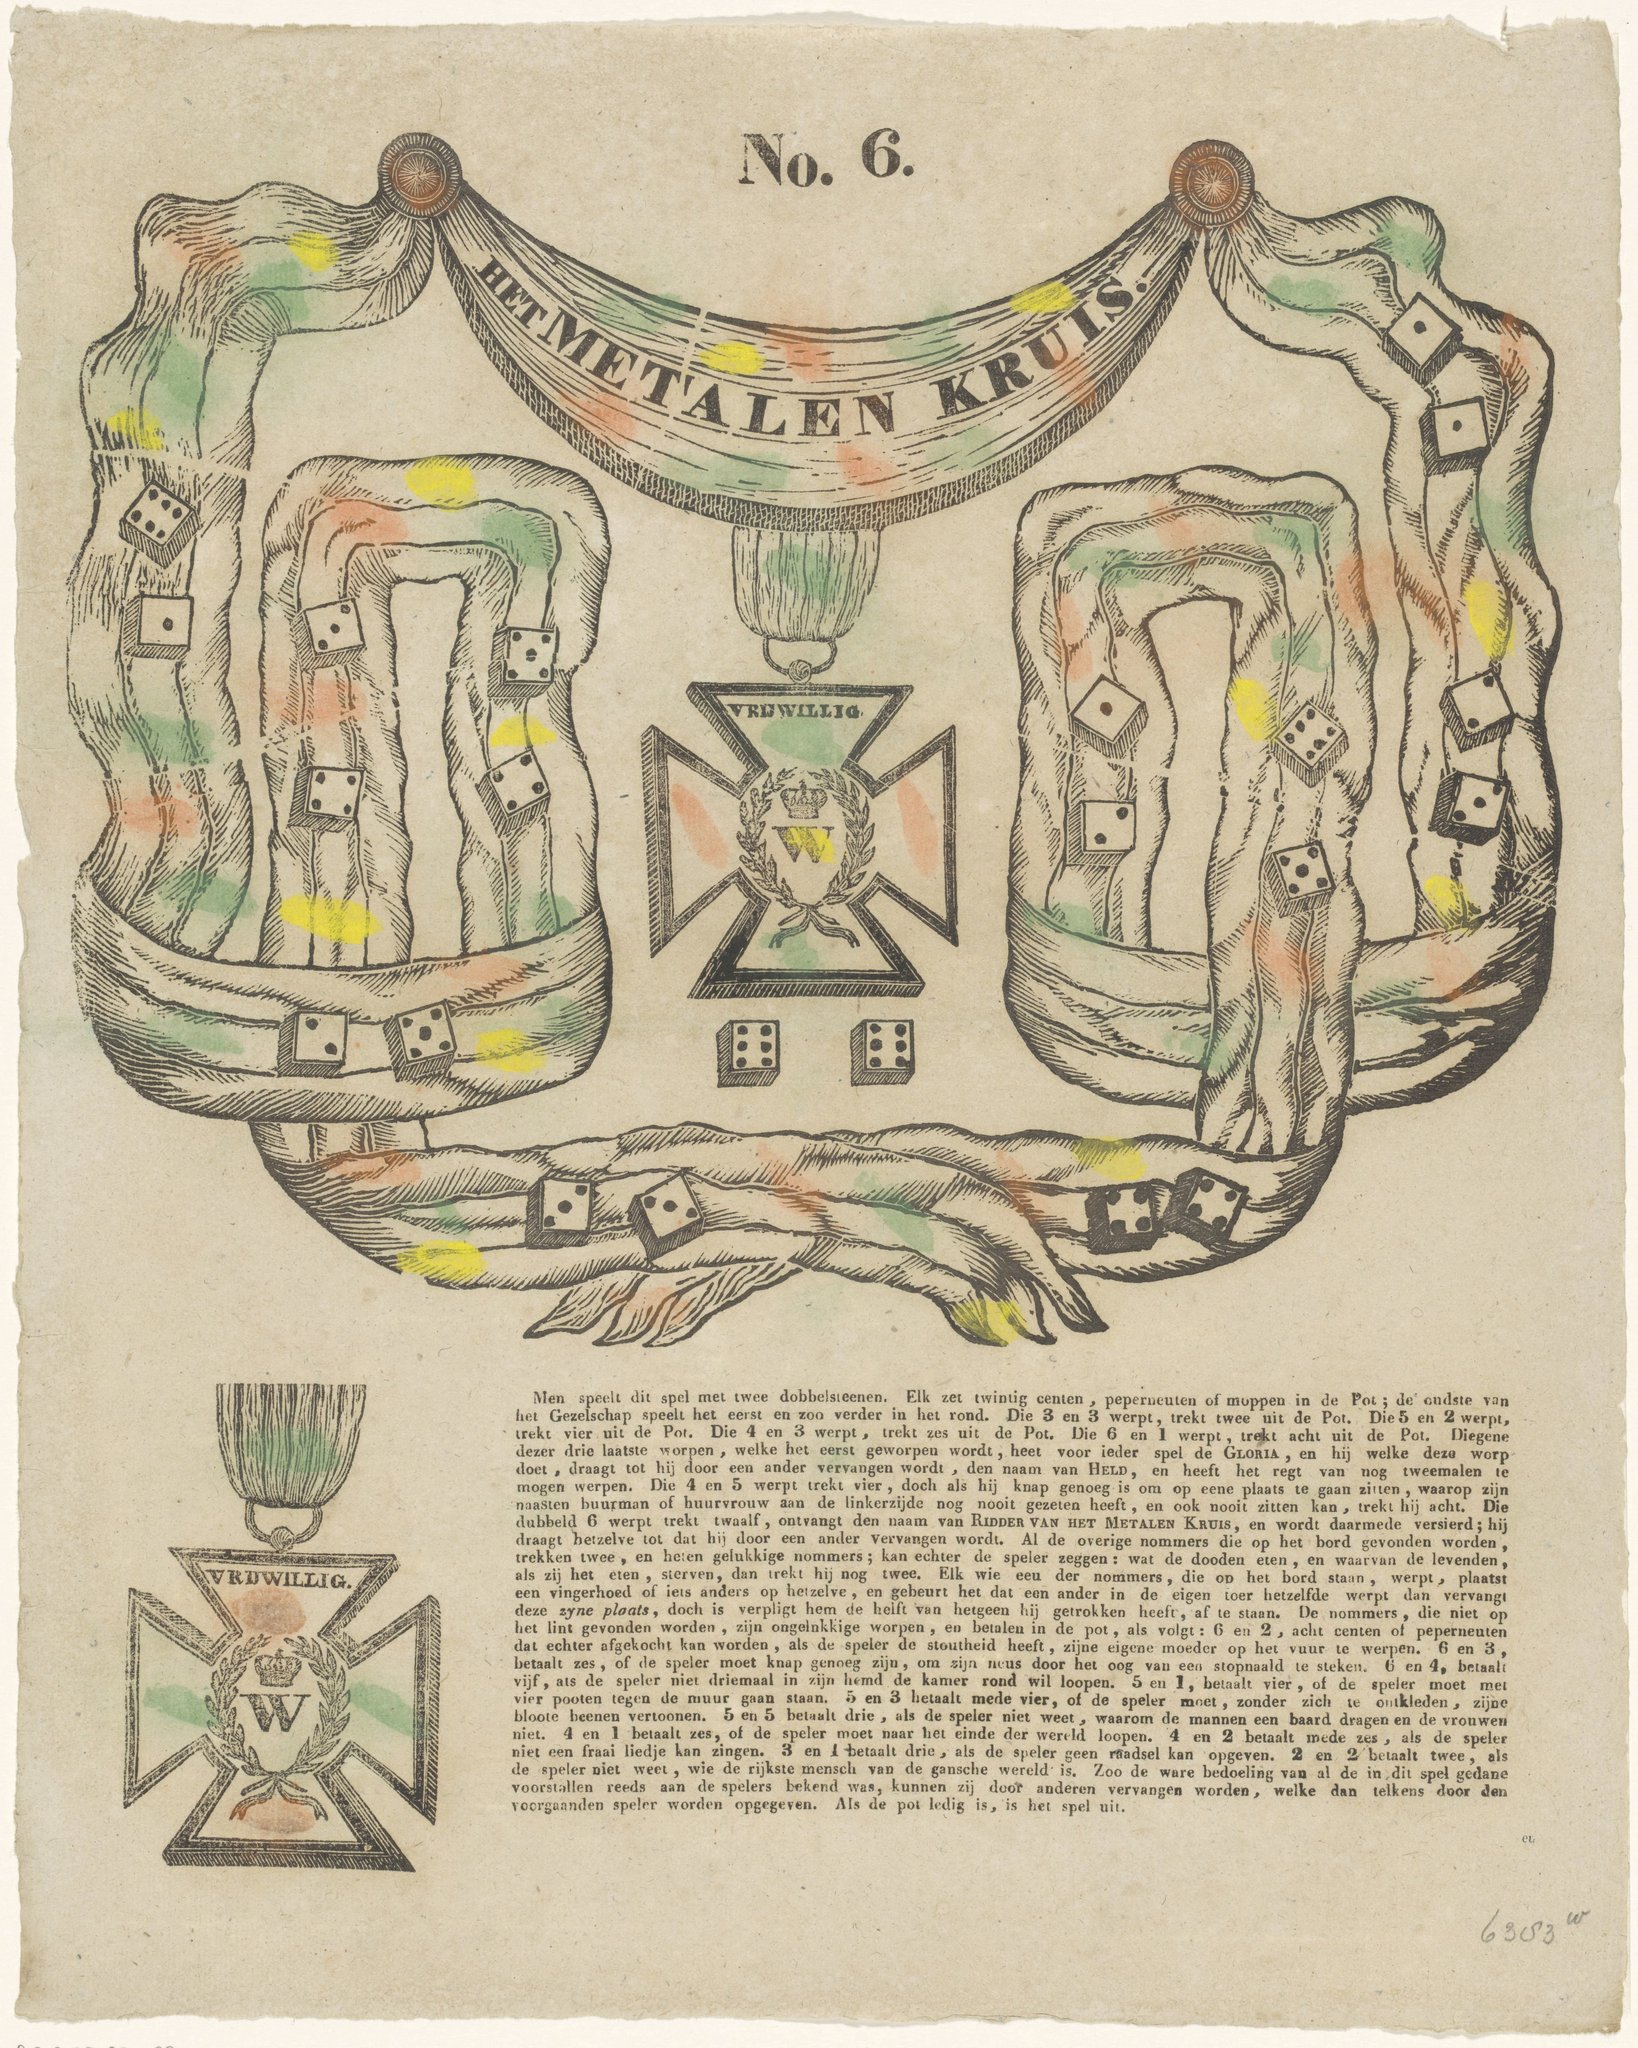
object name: print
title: Spel genaamd Het Metalen Kruis, 1832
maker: Anonymous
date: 1832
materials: paper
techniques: colour, letterpress printing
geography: netherlands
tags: medals and other marks of military honour, puzzle, riddle, conundrum, enigma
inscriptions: collector's mark: Lugt 2228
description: Bordspel genaamd Het Metalen Kruis, 1832. Centraal het ereteken verleend door koning Willem I aan allen die gevochten hadden tijdens de Belgische revolutie in 1830-1831. Om het kruis ligt een kronkelig lint met dobbelstenen. Linksonder nogmaals het Metalen Kruis, hiernaast de spelregels. Onderdeel van een groep van kinder- en gezelschapsspelen gedrukt in de periode ca. 1750-1850. Genummerd midden boven: No. 6.